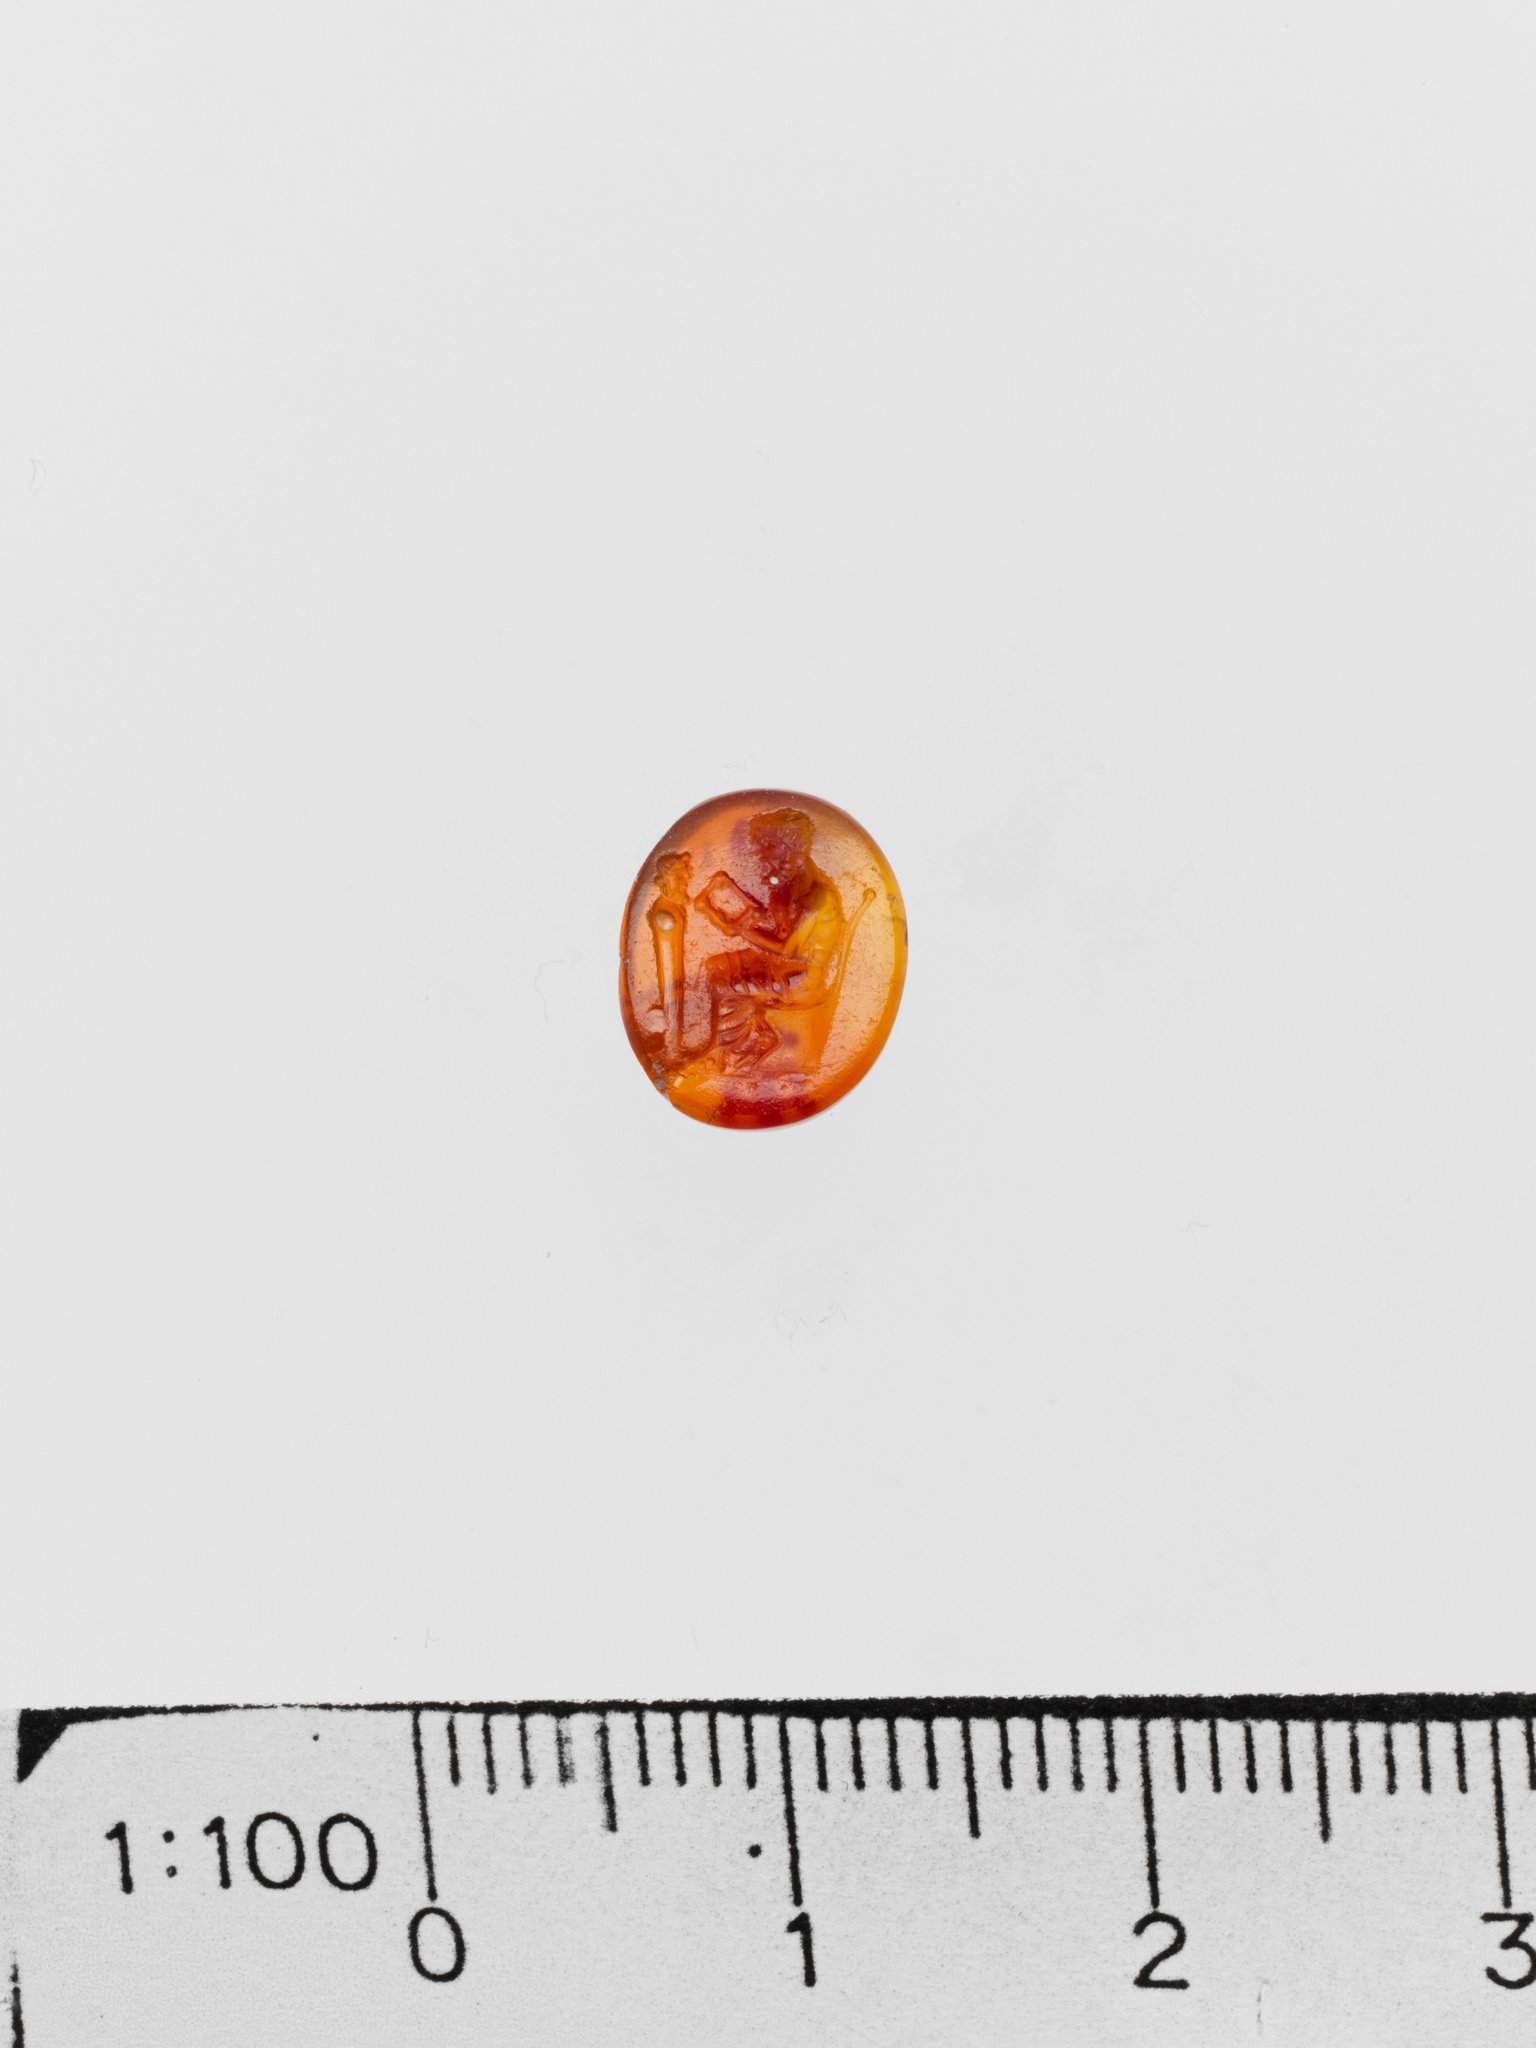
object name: intaglio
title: Carnelian ring stone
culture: roman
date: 1-100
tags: scrolls,men,reading,hermes